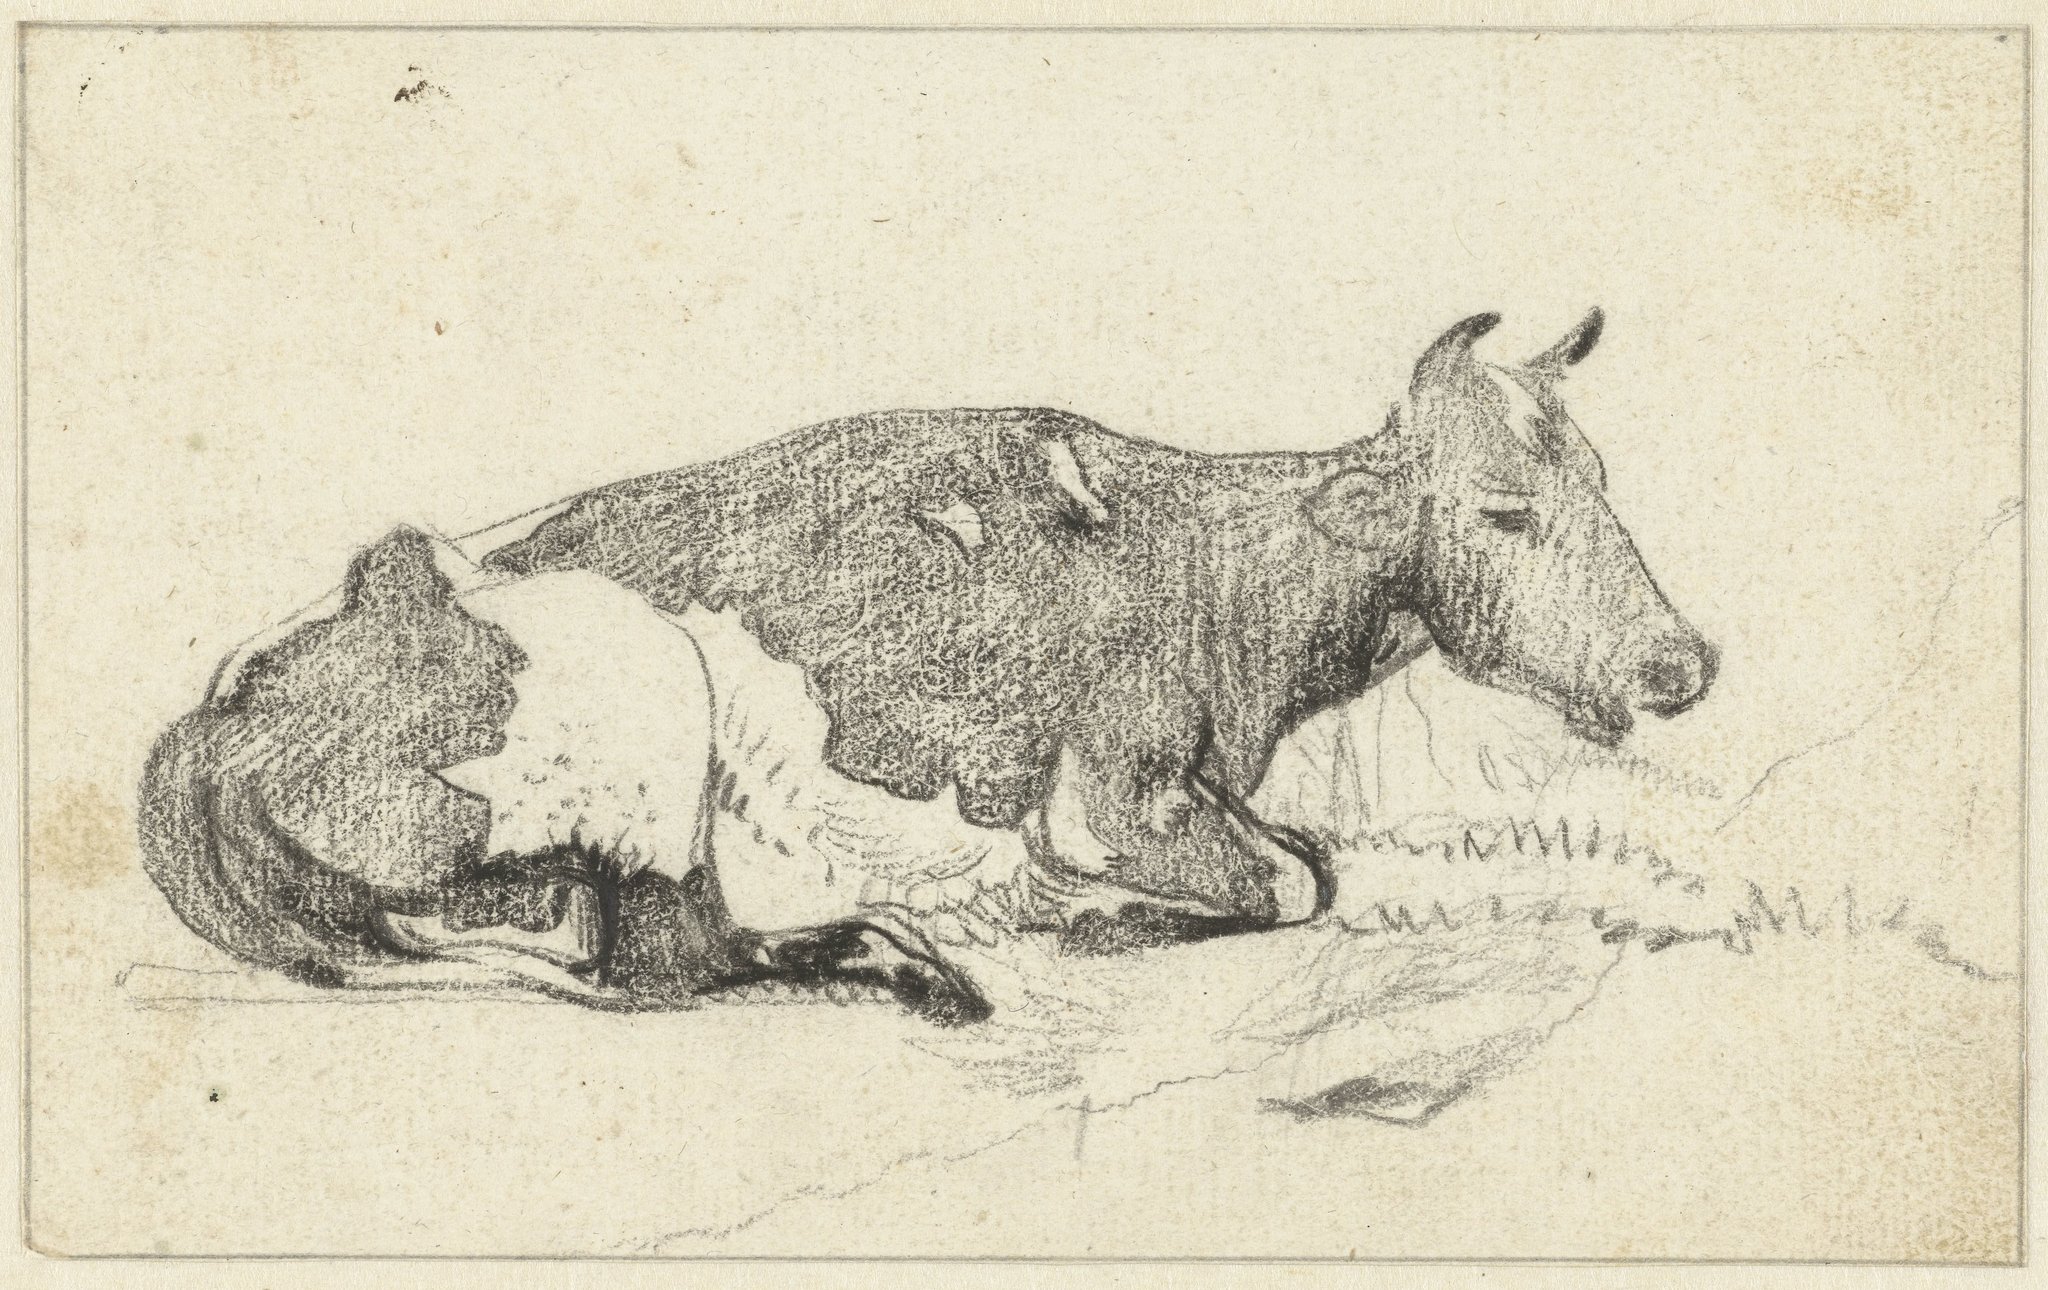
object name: drawing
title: Liggende koe, naar rechts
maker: pieter gerardus van os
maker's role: draughtsman, painter, print maker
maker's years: 1776-1839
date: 1786-1839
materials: chalk, paper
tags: cow